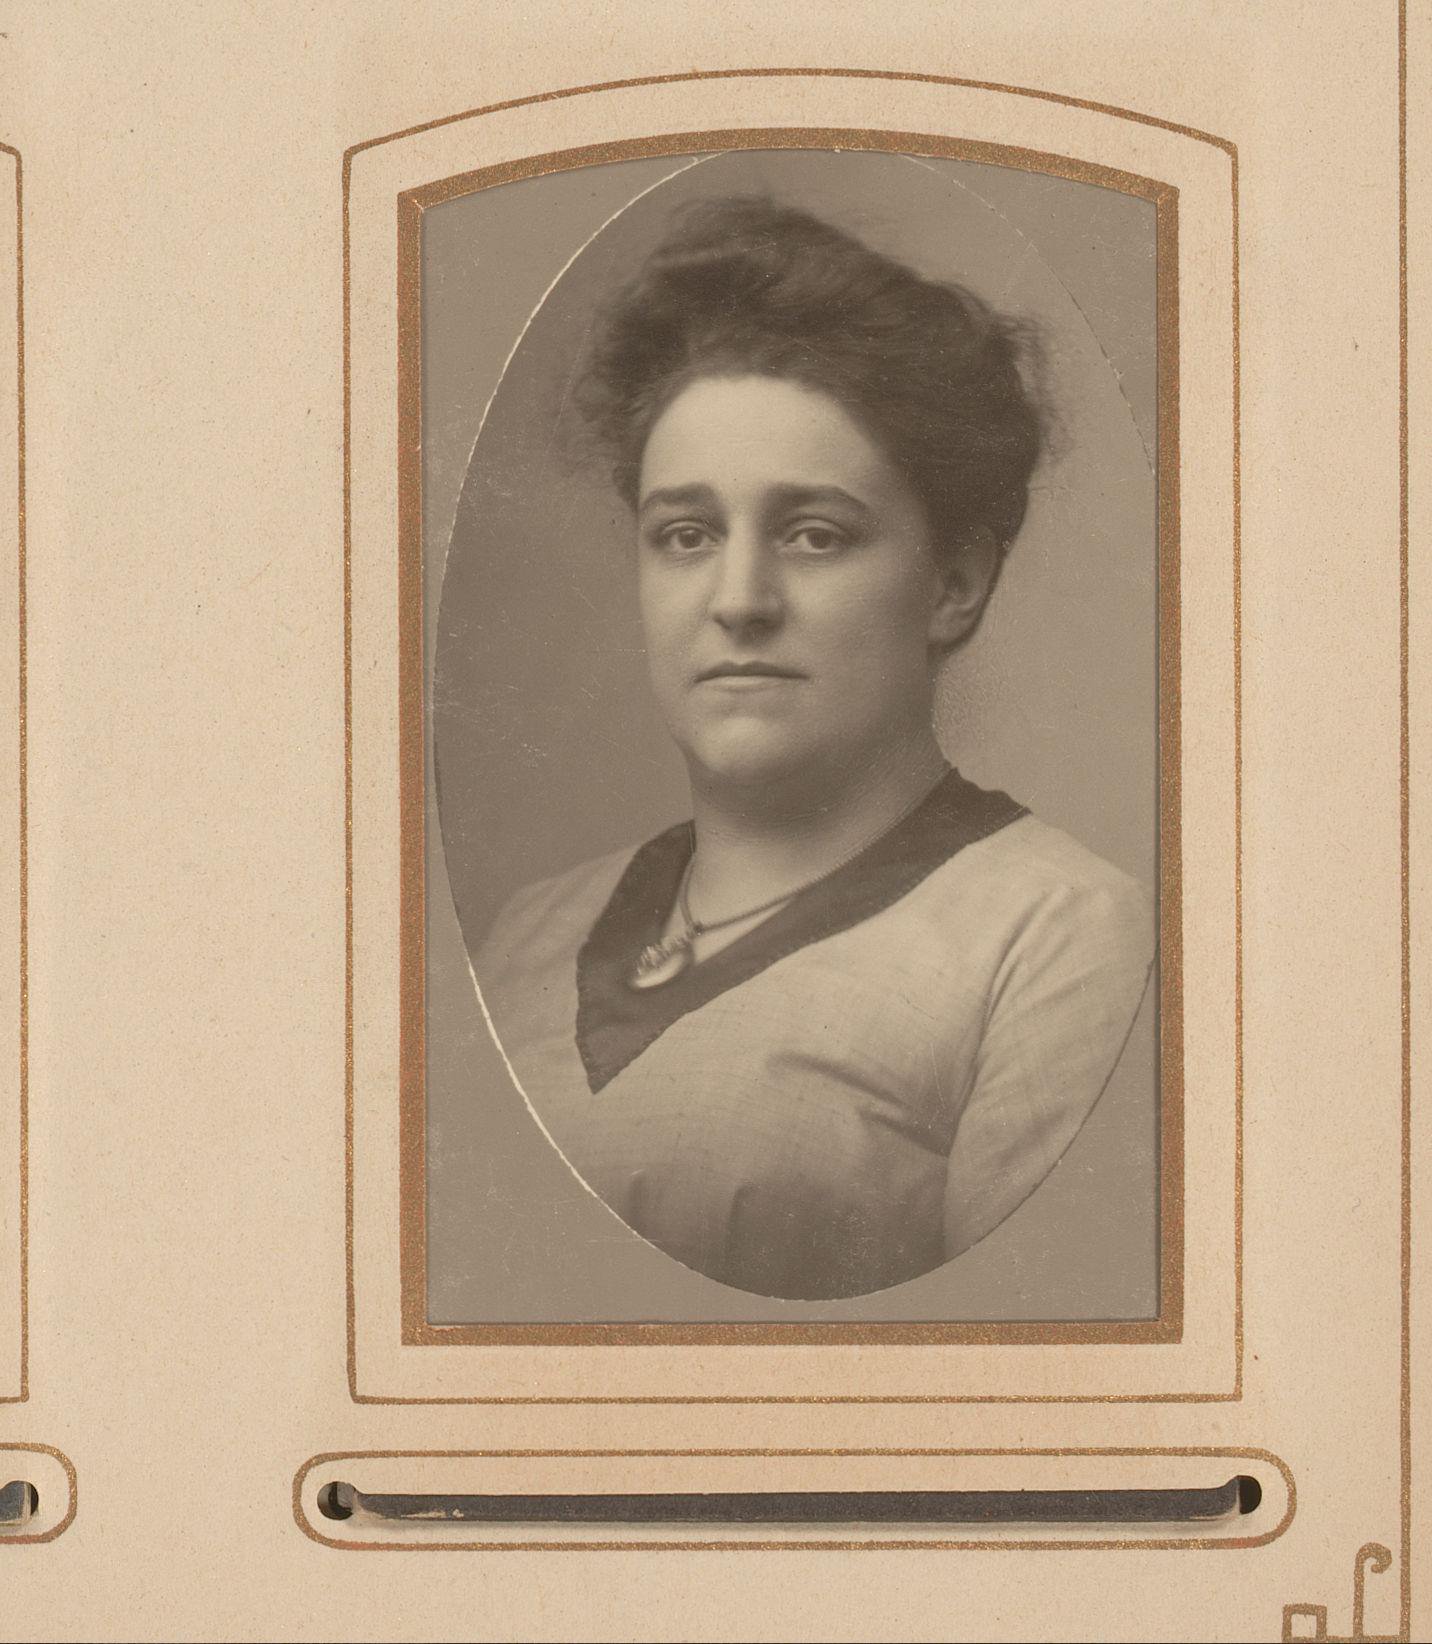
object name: album leaf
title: Portret van een vrouw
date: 1880-1910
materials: cardboard, photographic support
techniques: collodion silver print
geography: berlin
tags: historical persons - bb - woman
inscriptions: inscription: ‘Atelier W. Werthei/ Berlin/ Friedrichstr. 110-112’